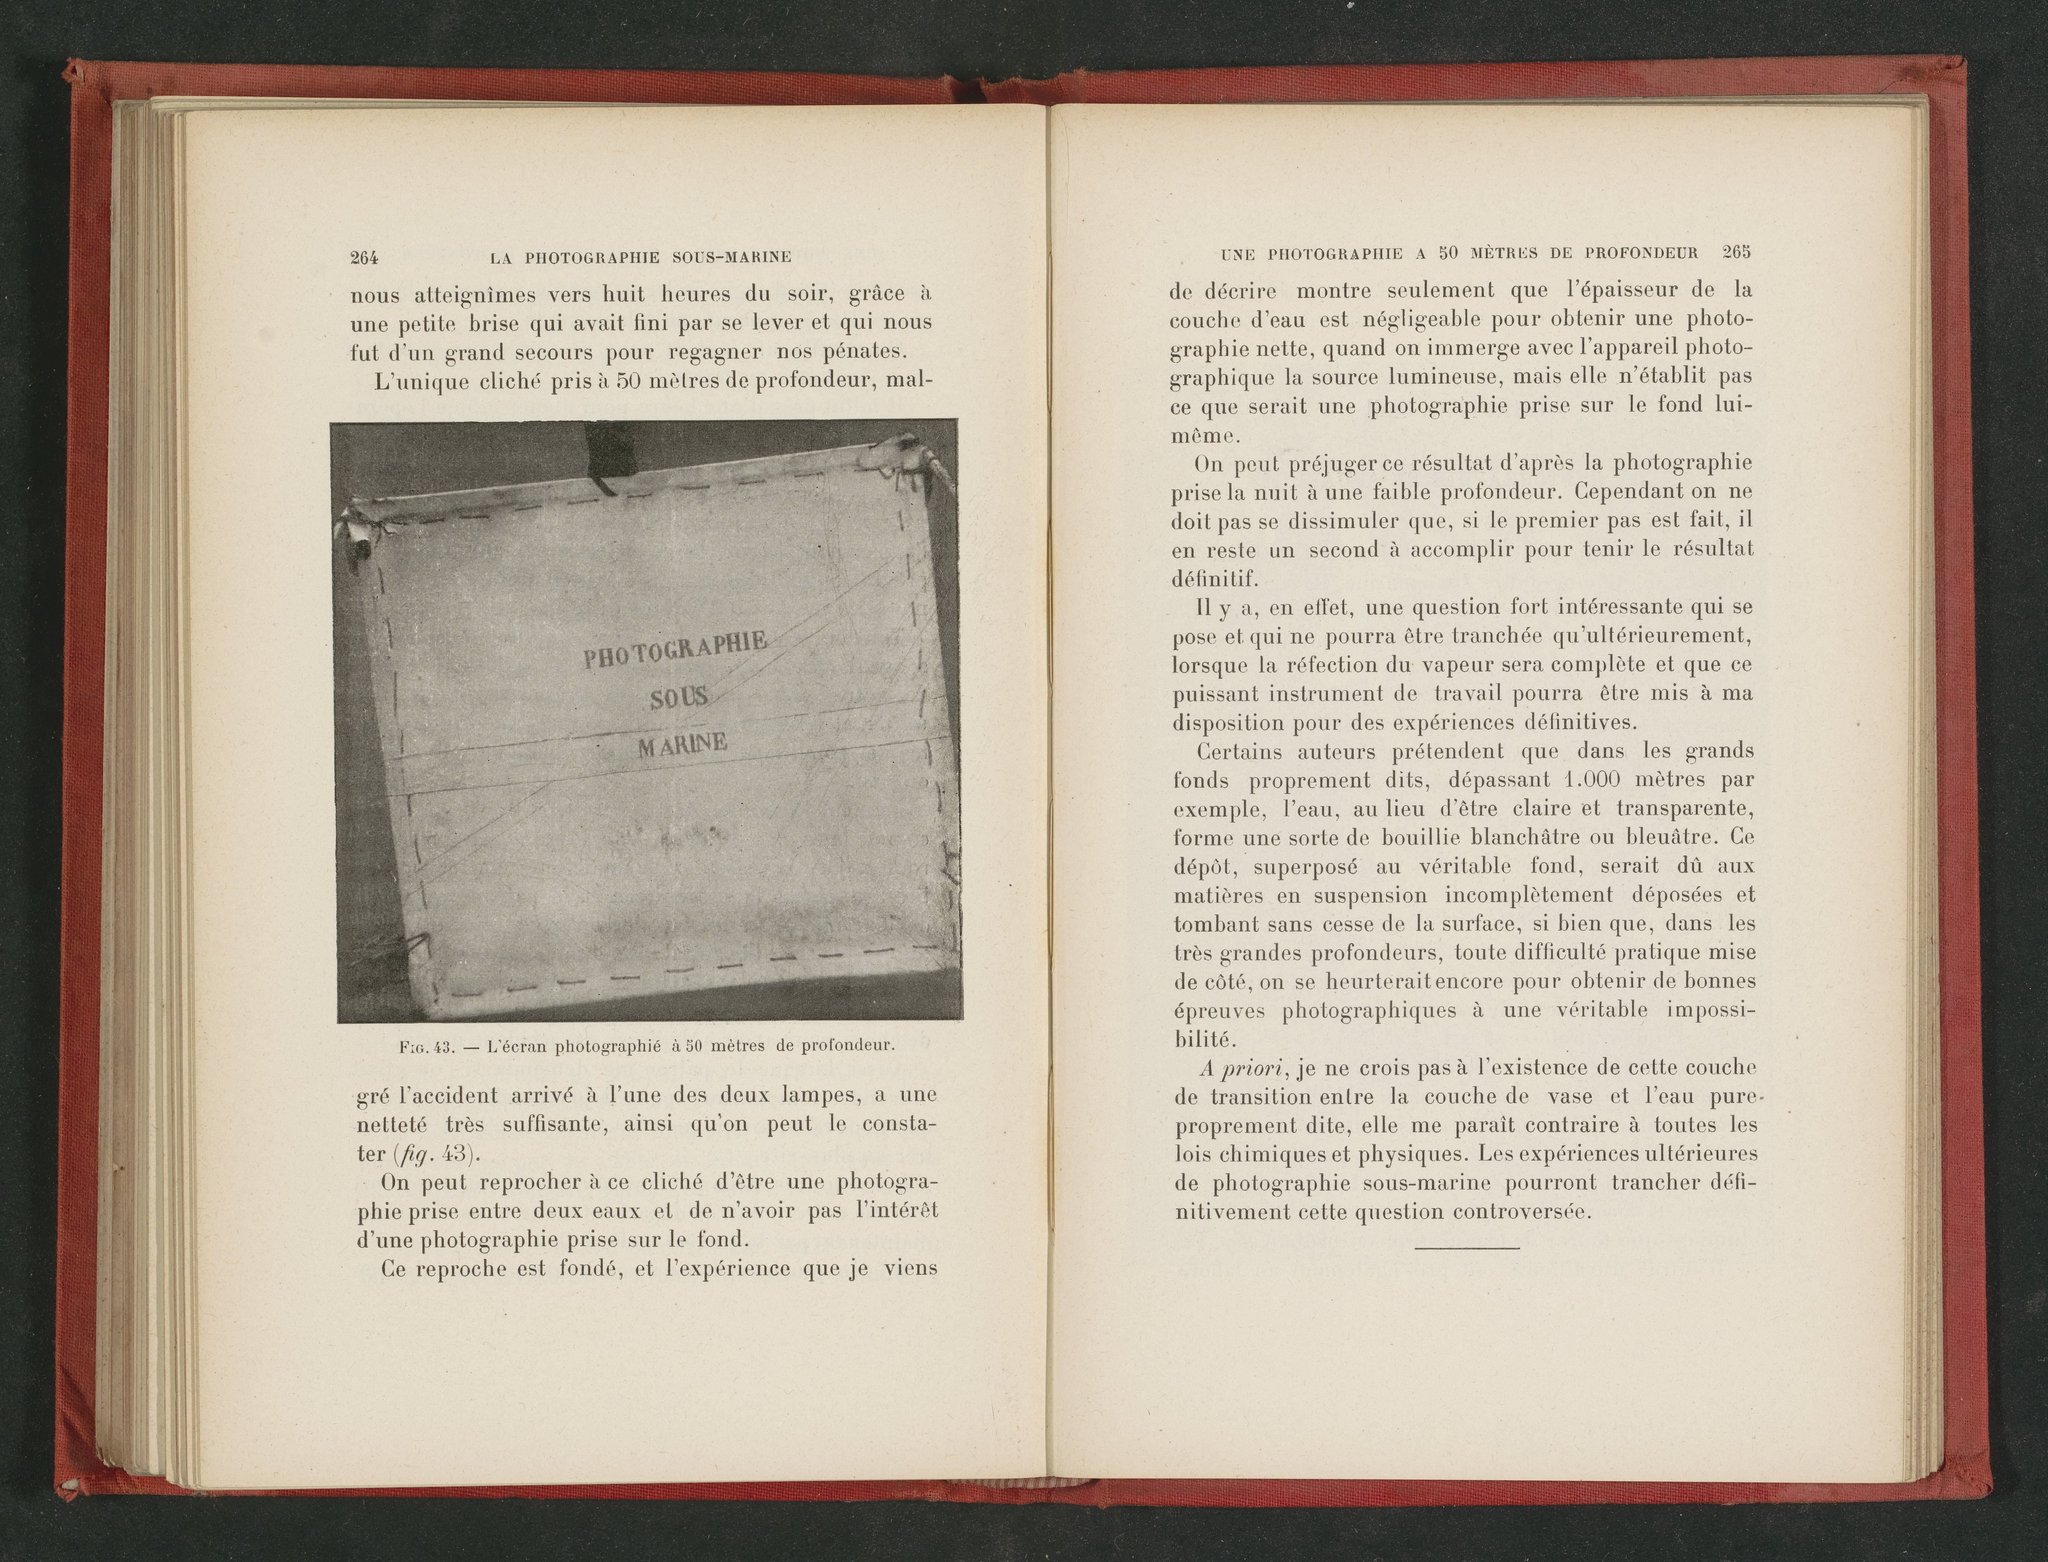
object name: photomechanical print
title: L'écran photographié à 50 mètres de profondeur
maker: Anonymous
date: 1890-1900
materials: paper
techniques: autotype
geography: france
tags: plank, board ~ building material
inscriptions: number: ‘Fig. 43.’